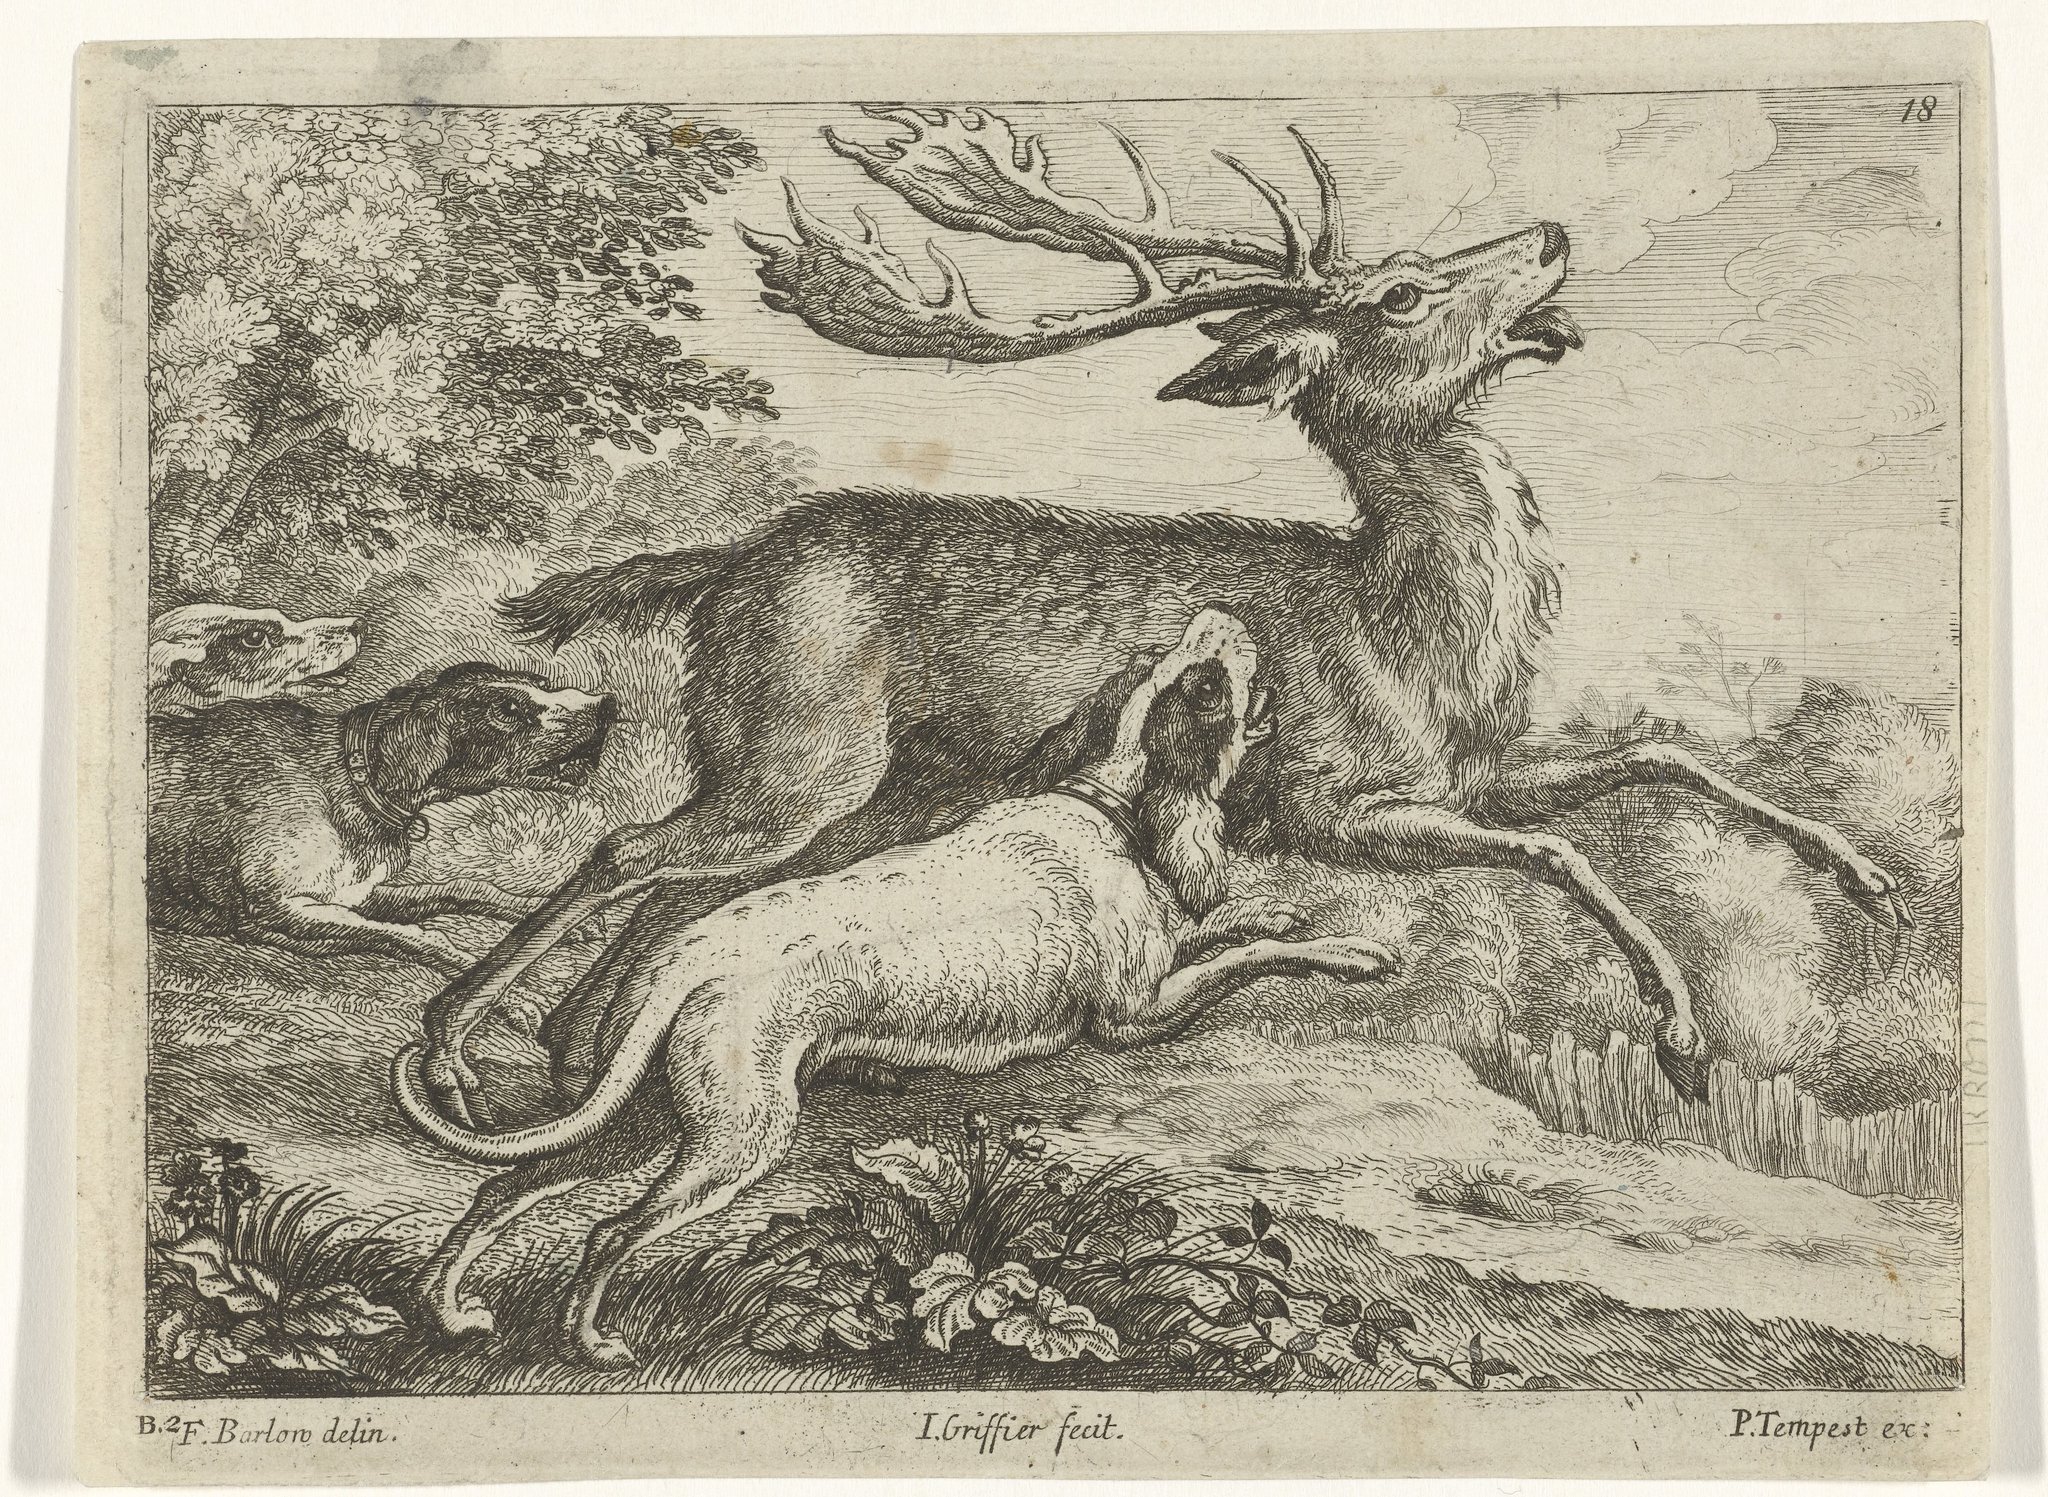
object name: print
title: Jacht op een hert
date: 1655-1718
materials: paper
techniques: engraving, etching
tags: hoofed animals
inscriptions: collector's mark: Lugt 2228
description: Drie honden jagen op een hert in een bosrijke omgeving. Deze prent maakt deel uit van een serie van tien prenten met verschillende dieren.